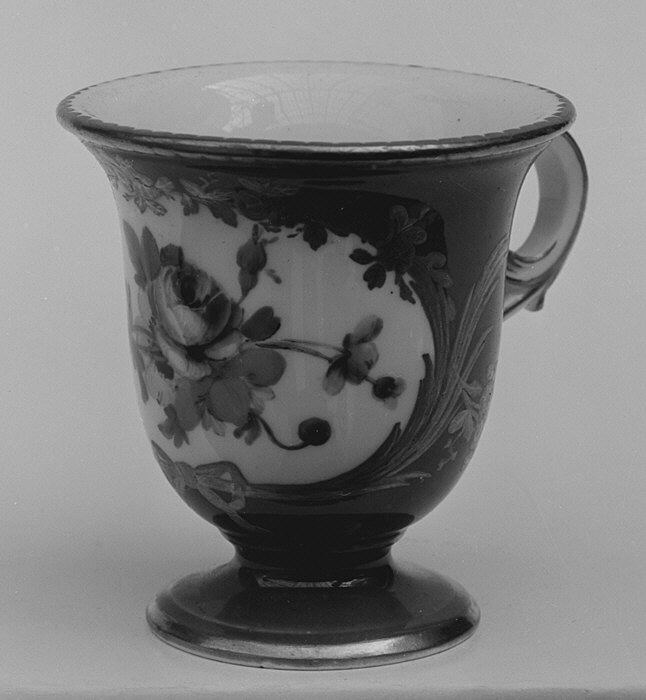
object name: ice cream cup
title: Ice cream cup (tasse à glace) (one of thirty-one) (part of a service)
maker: sèvres manufactory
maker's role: manufactory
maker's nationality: french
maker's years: 1740-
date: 1780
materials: soft paste porcelain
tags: flowers